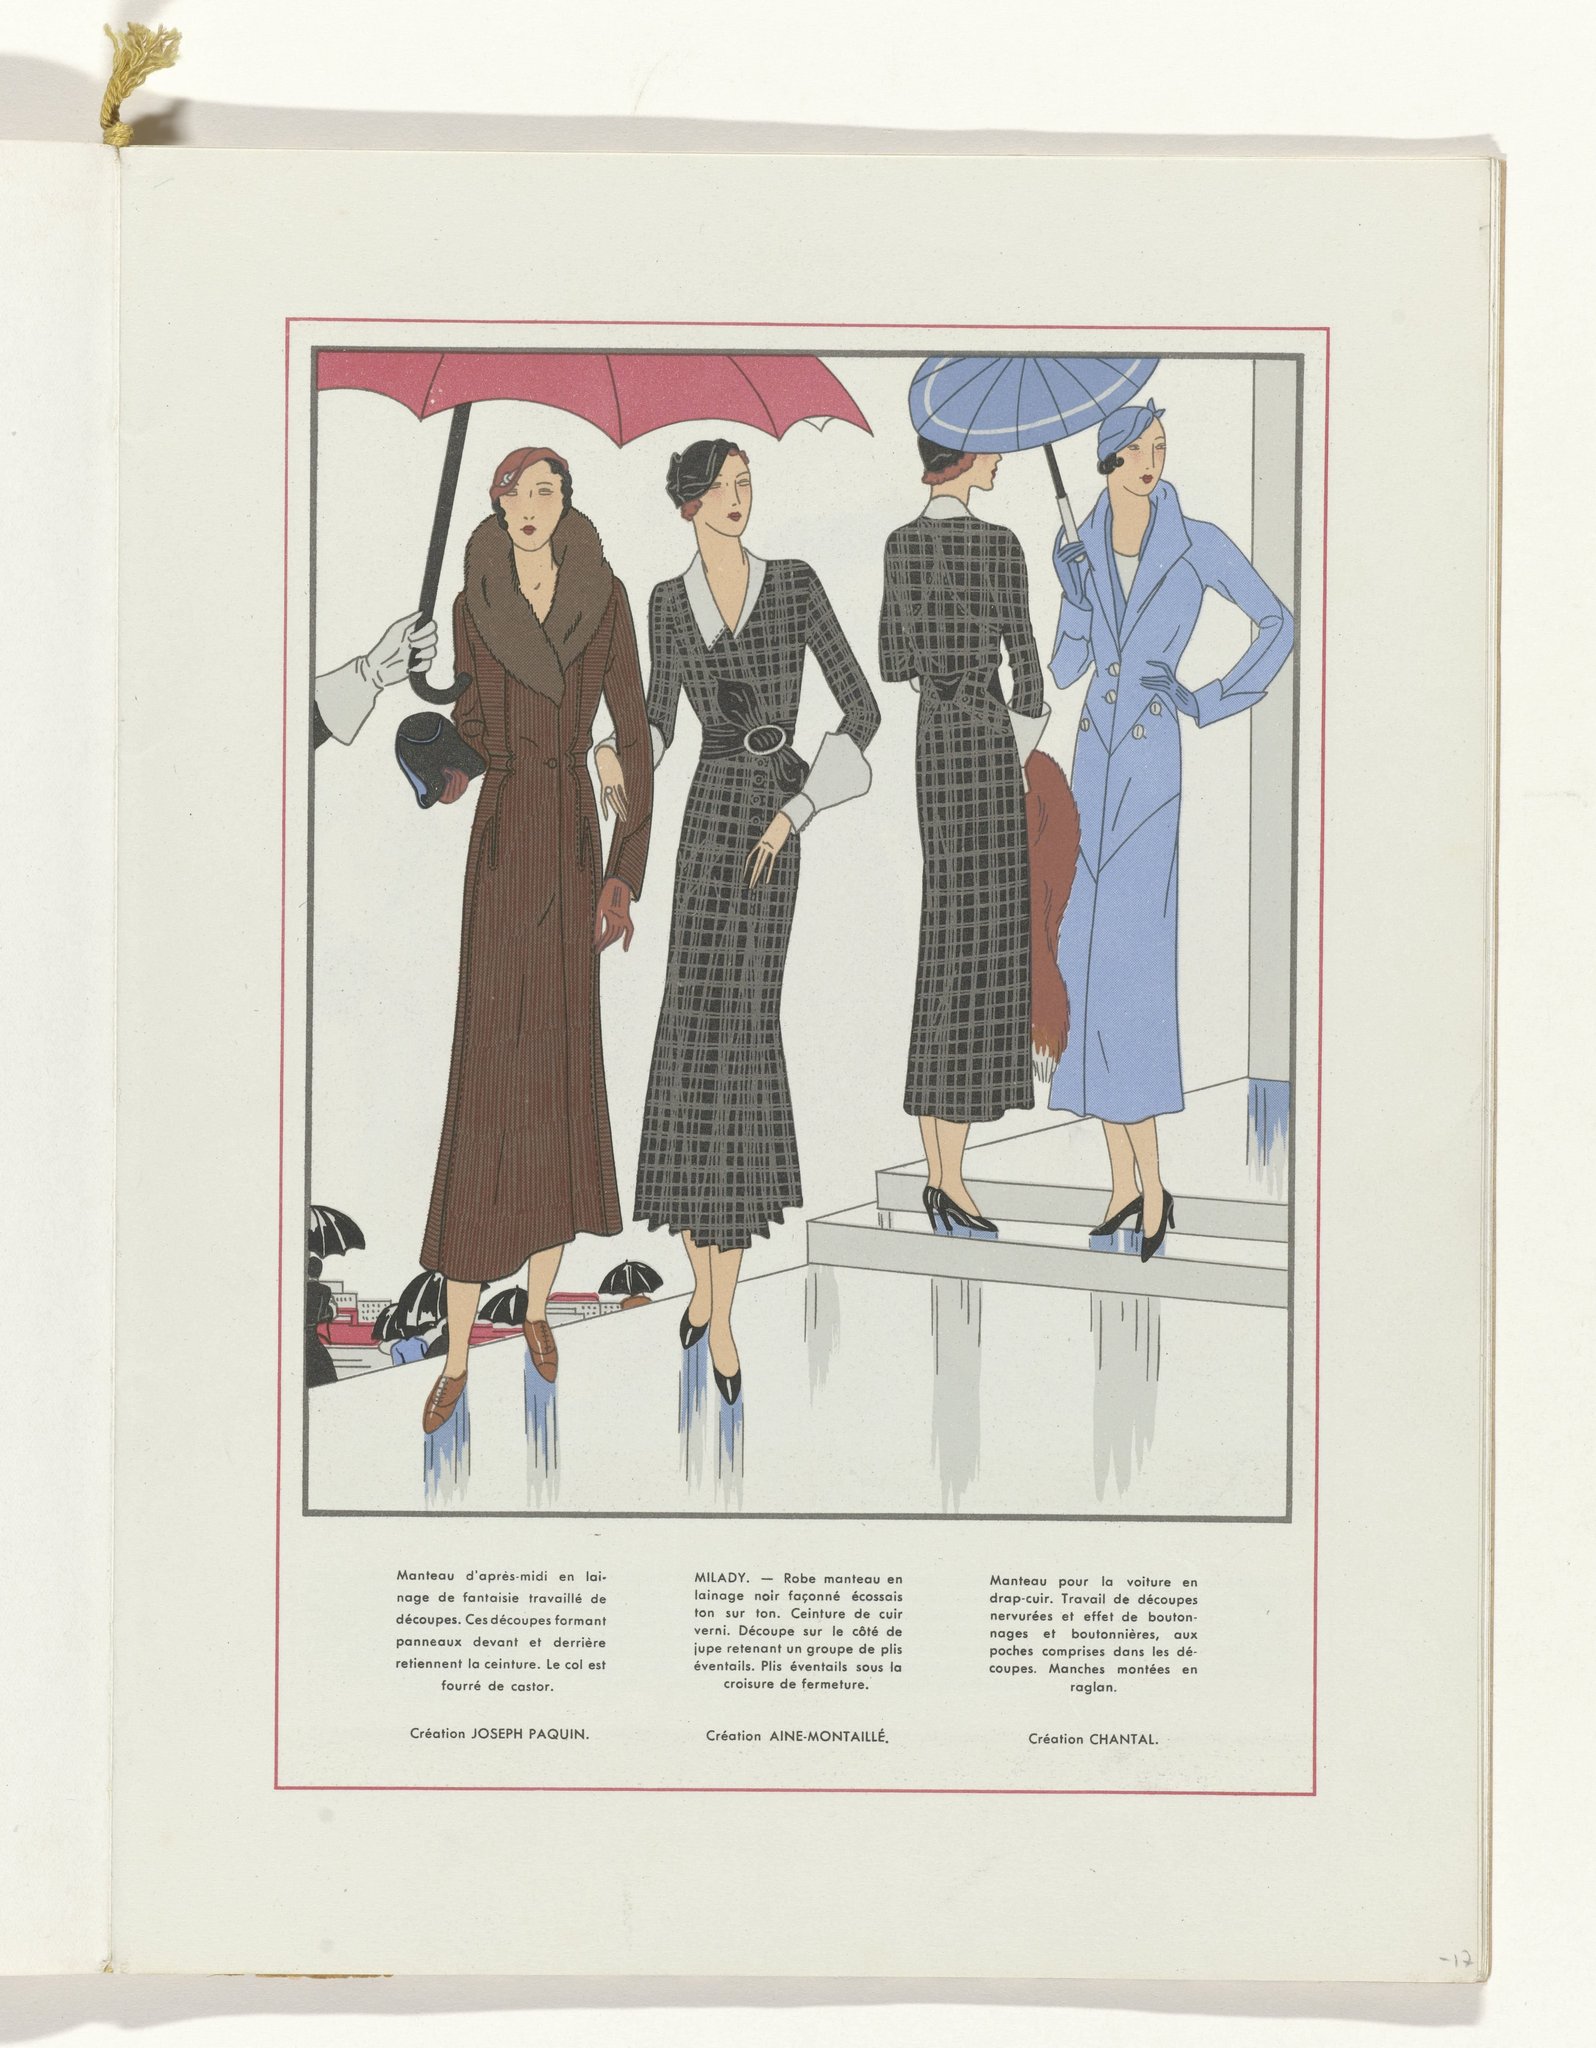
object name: fashion print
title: Art - Goût - Beauté, Feuillets de l' élégance féminine, Novembre 1931, No. 135, 12e Année, p. 17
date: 1931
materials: paper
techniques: printing, hand coloring, lithograph, photography, pochoir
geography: paris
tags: bag (handbag) (+ women's clothes), dress, gown (robe manteau) (+ women's clothes), coat (+ women's clothes), fashion plates, head-gear: hat (+ women's clothes), neck-gear: collar (+ fur used for clothes), belt, girdle, waistband (+ women's clothes)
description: Links: mantel voor de middag van wol met een kraag van castor (beverbont), van Joseph Paquin. Midden: 'robe manteau' (jasjurk) van Schots geruite zwarte wol. Ceintuur van zwart lakleer. Ontwerp van Aine-Montaillé. Rechts: mantel voor in de auto van 'drap-cuir', van Chantal. Pagina uit het modetijdschrift Art-Goût-Beauté (1920-1933).